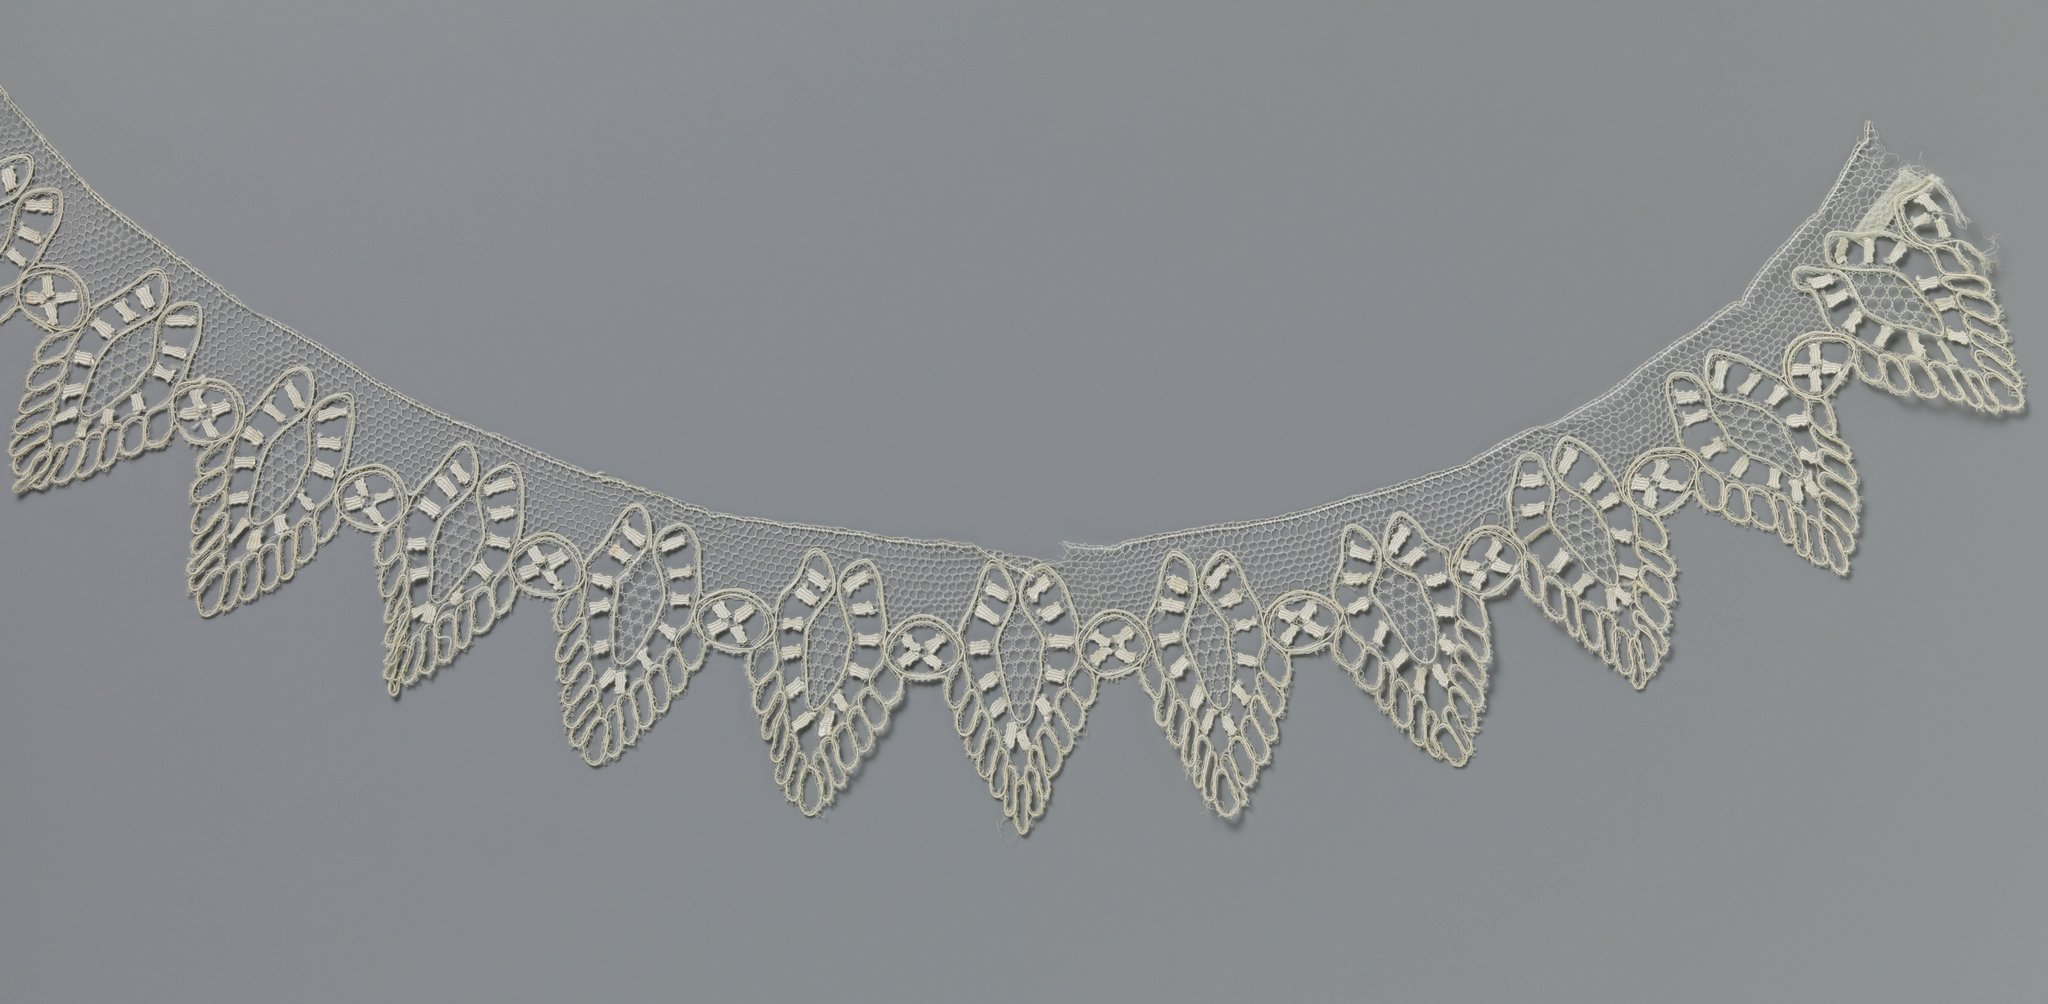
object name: strip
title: Strook vaagblauw kloskant met ovalen die diepe puntige schulpen vormen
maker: Anonymous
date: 1925-1949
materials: silk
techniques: lace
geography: france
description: Strook naturelkleurige kloskant: blonde. De kleur neigt vaag naar blauw. Het zich herhalende patroon bestaat uit een ovaal met één spitse punt, die naar beneden hangt en een diepe schulp vormt. De opeenvolgende schulpen zijn met elkaar verbonden door een opengewerkte cirkel, waarin een x-vormig motief is gemaakt in vormslag. De ovalen zijn gevormd door een siergrond, een rozengrond, waar een brede opengewerkte baan omheen loopt van contourdraden waartussen blokjes staan die zijn gemaakt in vormslag. Om het onderste gedeelte van de ovalen loopt nog een extra sierband, die wordt gevormd door een aaneenschakeling van opengewerkte en met fijne picots afgewerkte ovalen. De contourdraden bestaan uit een combinatie van een bundel flosdraden en een getwijnde draad. Aan de bovenkant zijn de motieven met elkaar verbonden door een traliegrond, een tulegrond. De bovenzijde is recht afgewerkt.